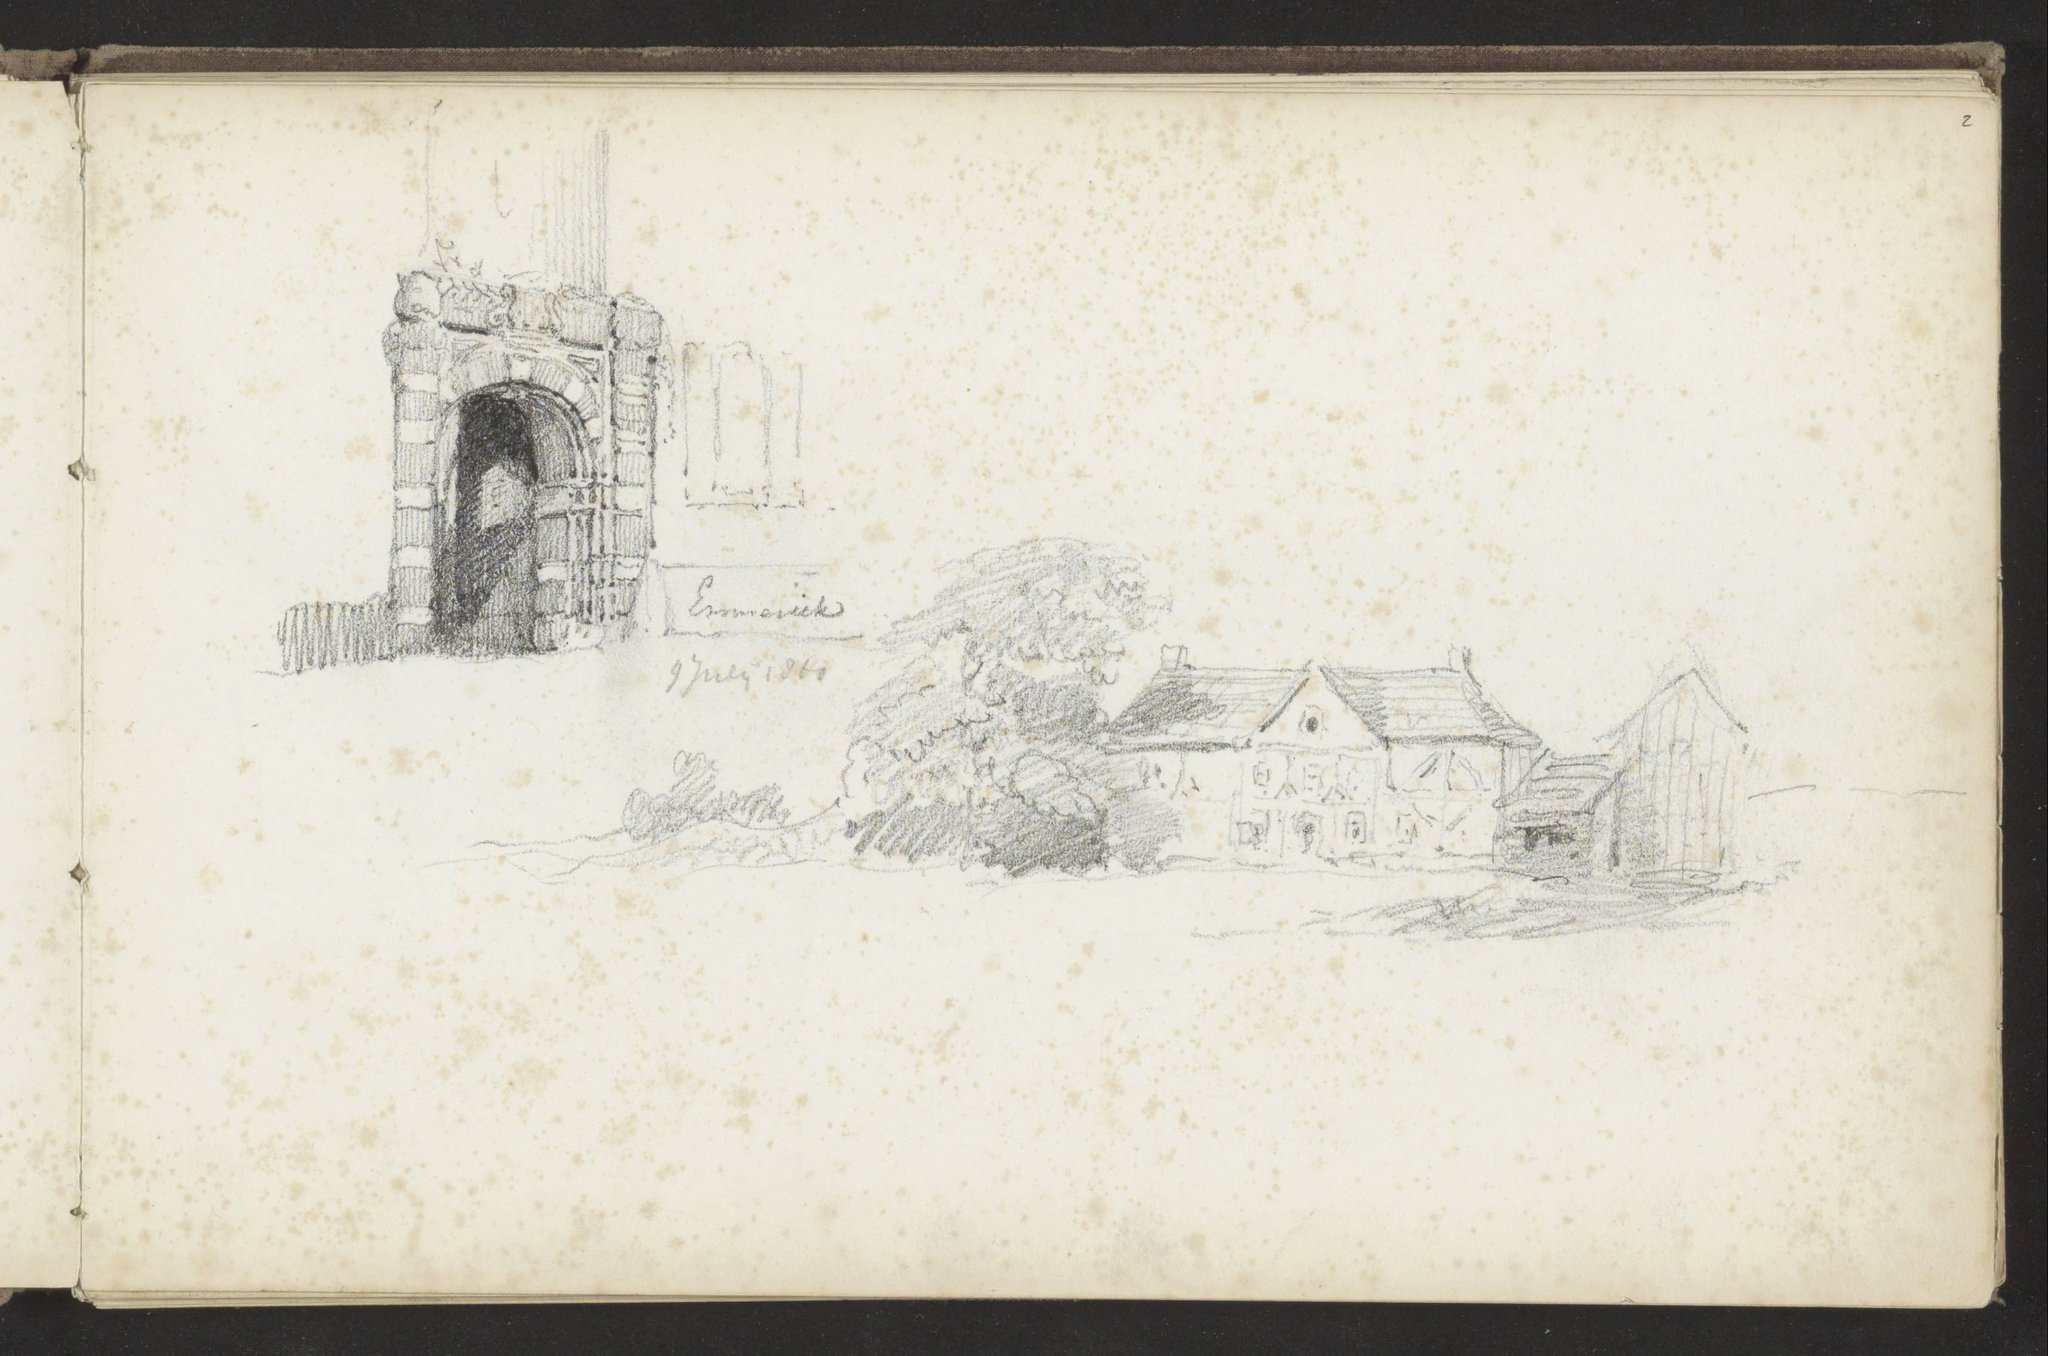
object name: sketchbook leaf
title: Landhuis en een portaal van een huis in Emmerik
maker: maria vos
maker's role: draughtsman, painter, print maker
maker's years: 1824-1906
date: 1807-1860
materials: paper, pencil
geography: emmerik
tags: country-house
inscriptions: date and inscription: ‘Emmerick/ 9 July 1860’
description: Blad 2 recto uit een schetsboek met 55 bladen.